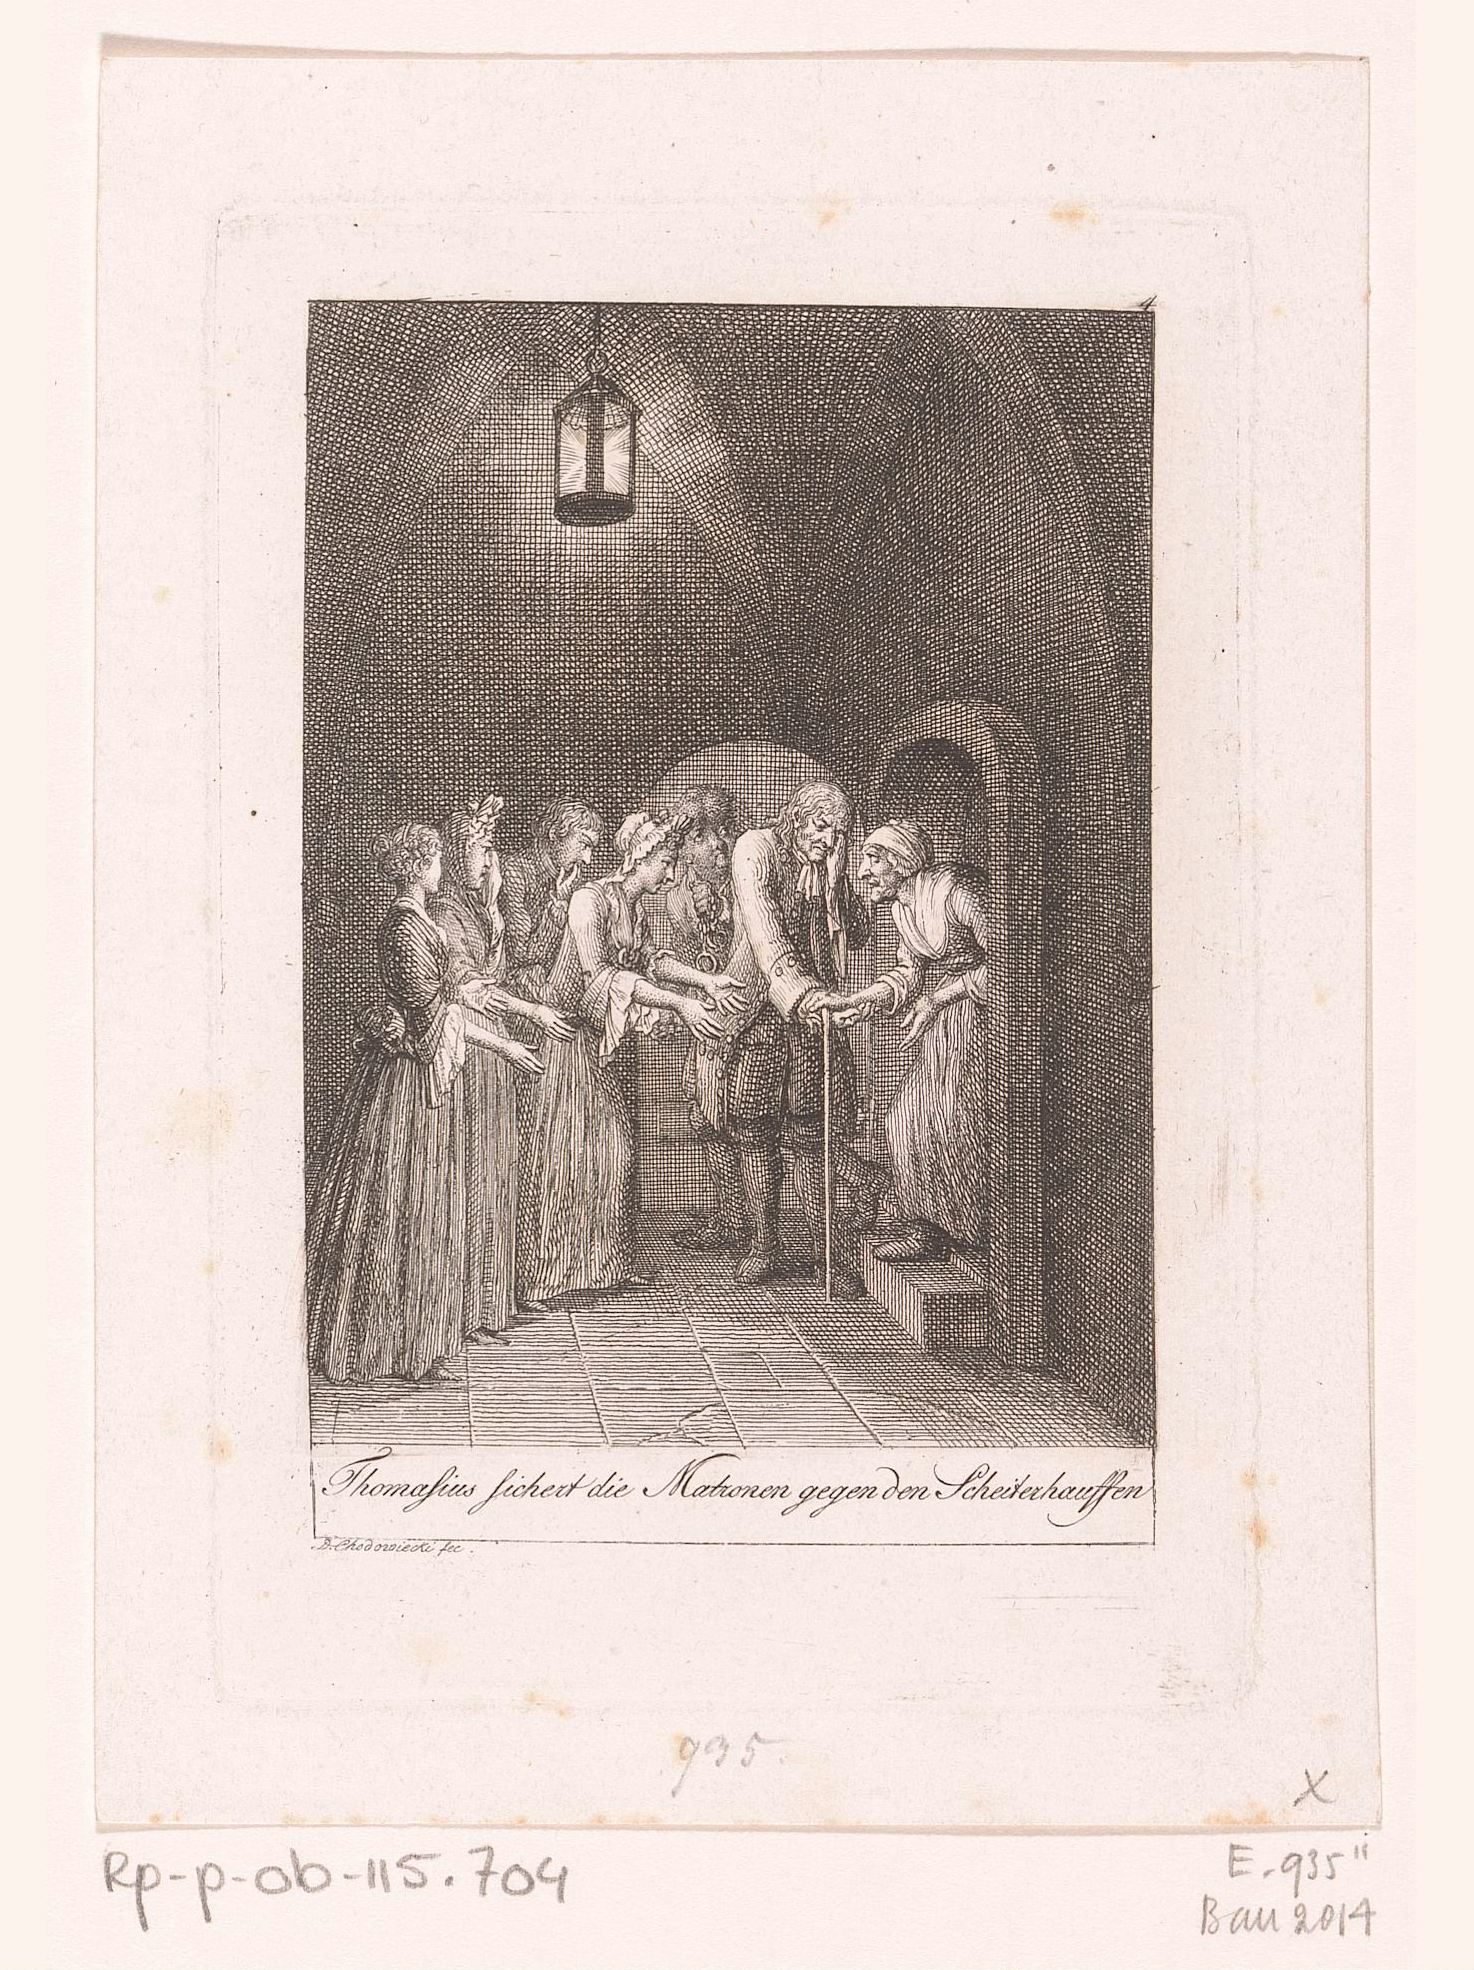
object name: print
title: Christian Thomasius helpt een van hekserij verdachte oude vrouw de cel uit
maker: daniel nikolaus chodowiecki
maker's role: draughtsman, print maker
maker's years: 1726-1801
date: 1800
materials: paper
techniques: etching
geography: berlin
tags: christian thomasius, witch-hunt, persecution of witches and sorcerers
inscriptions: collector's mark: Lugt 2228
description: Prent gebruikt voor: Salzmann, Christian Gotthilf. Taschenbuch zur Beförderung der Vaterlandsliebe. Auf das Jahr 1801 (...). Schnepfenthal: s.n., 1801.